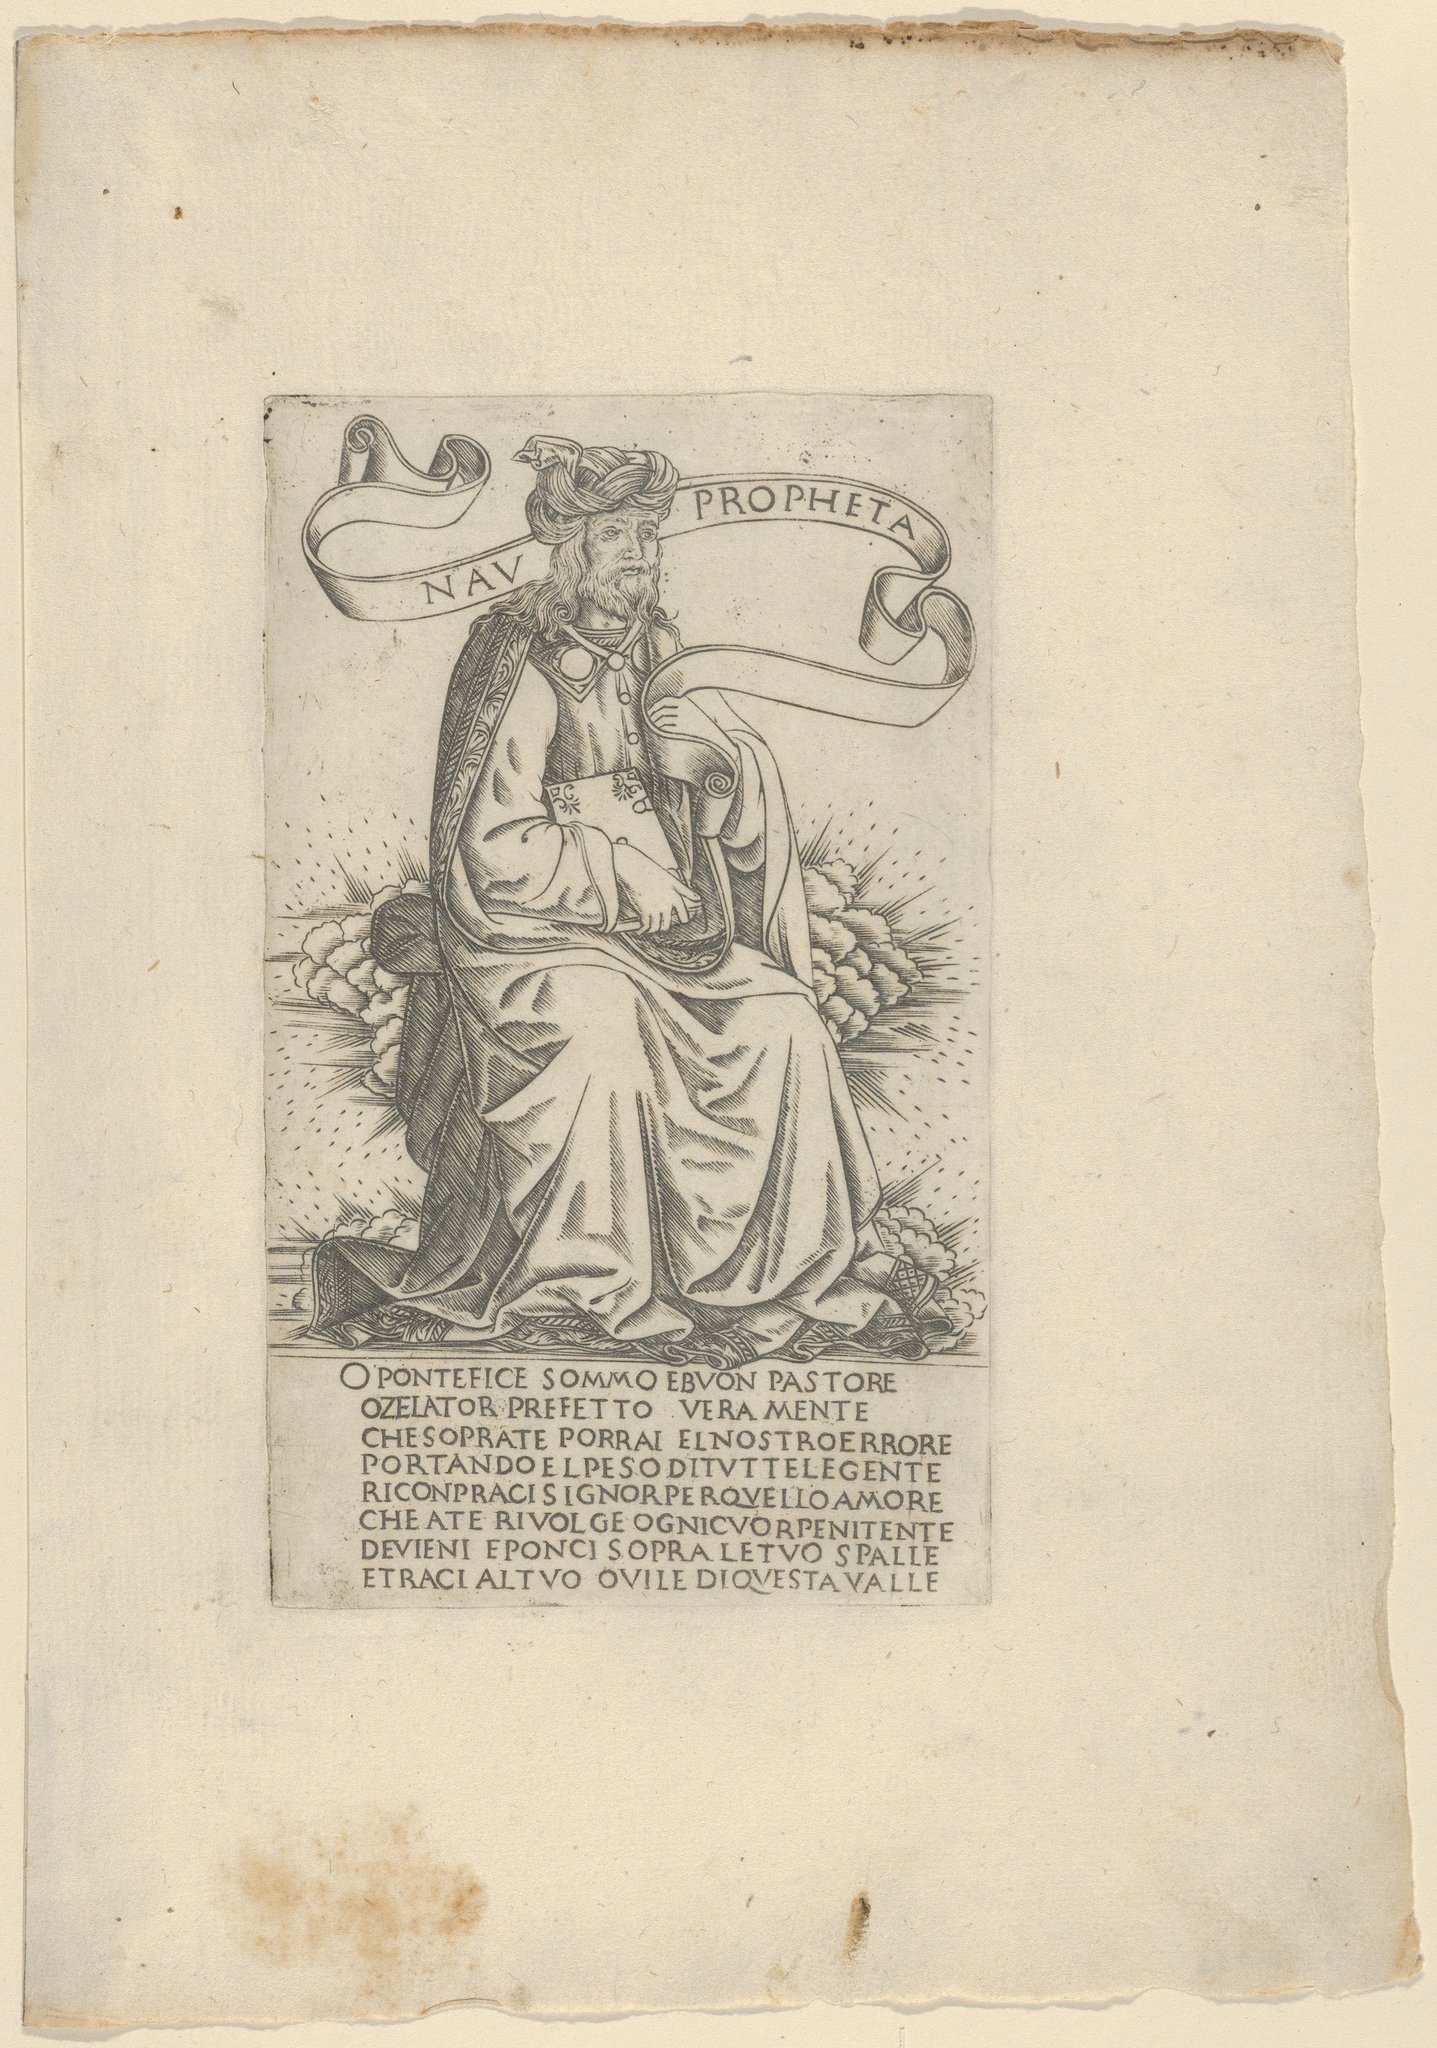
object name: print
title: The Prophet Nahum, from Prophets and Sibyls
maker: francesco rosselli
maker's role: artist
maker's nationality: italian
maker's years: 1448-1527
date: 1480-1490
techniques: engraving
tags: men,portraits